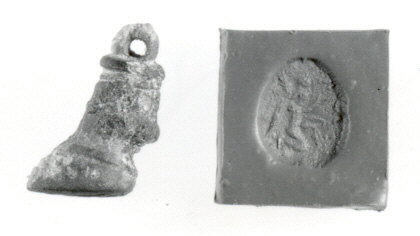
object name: stamp seal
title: Stamp seal (hoof with loop handle) with divine being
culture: urartian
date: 800-601 BCE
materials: alloy, bronze, copper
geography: urartu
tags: bulls